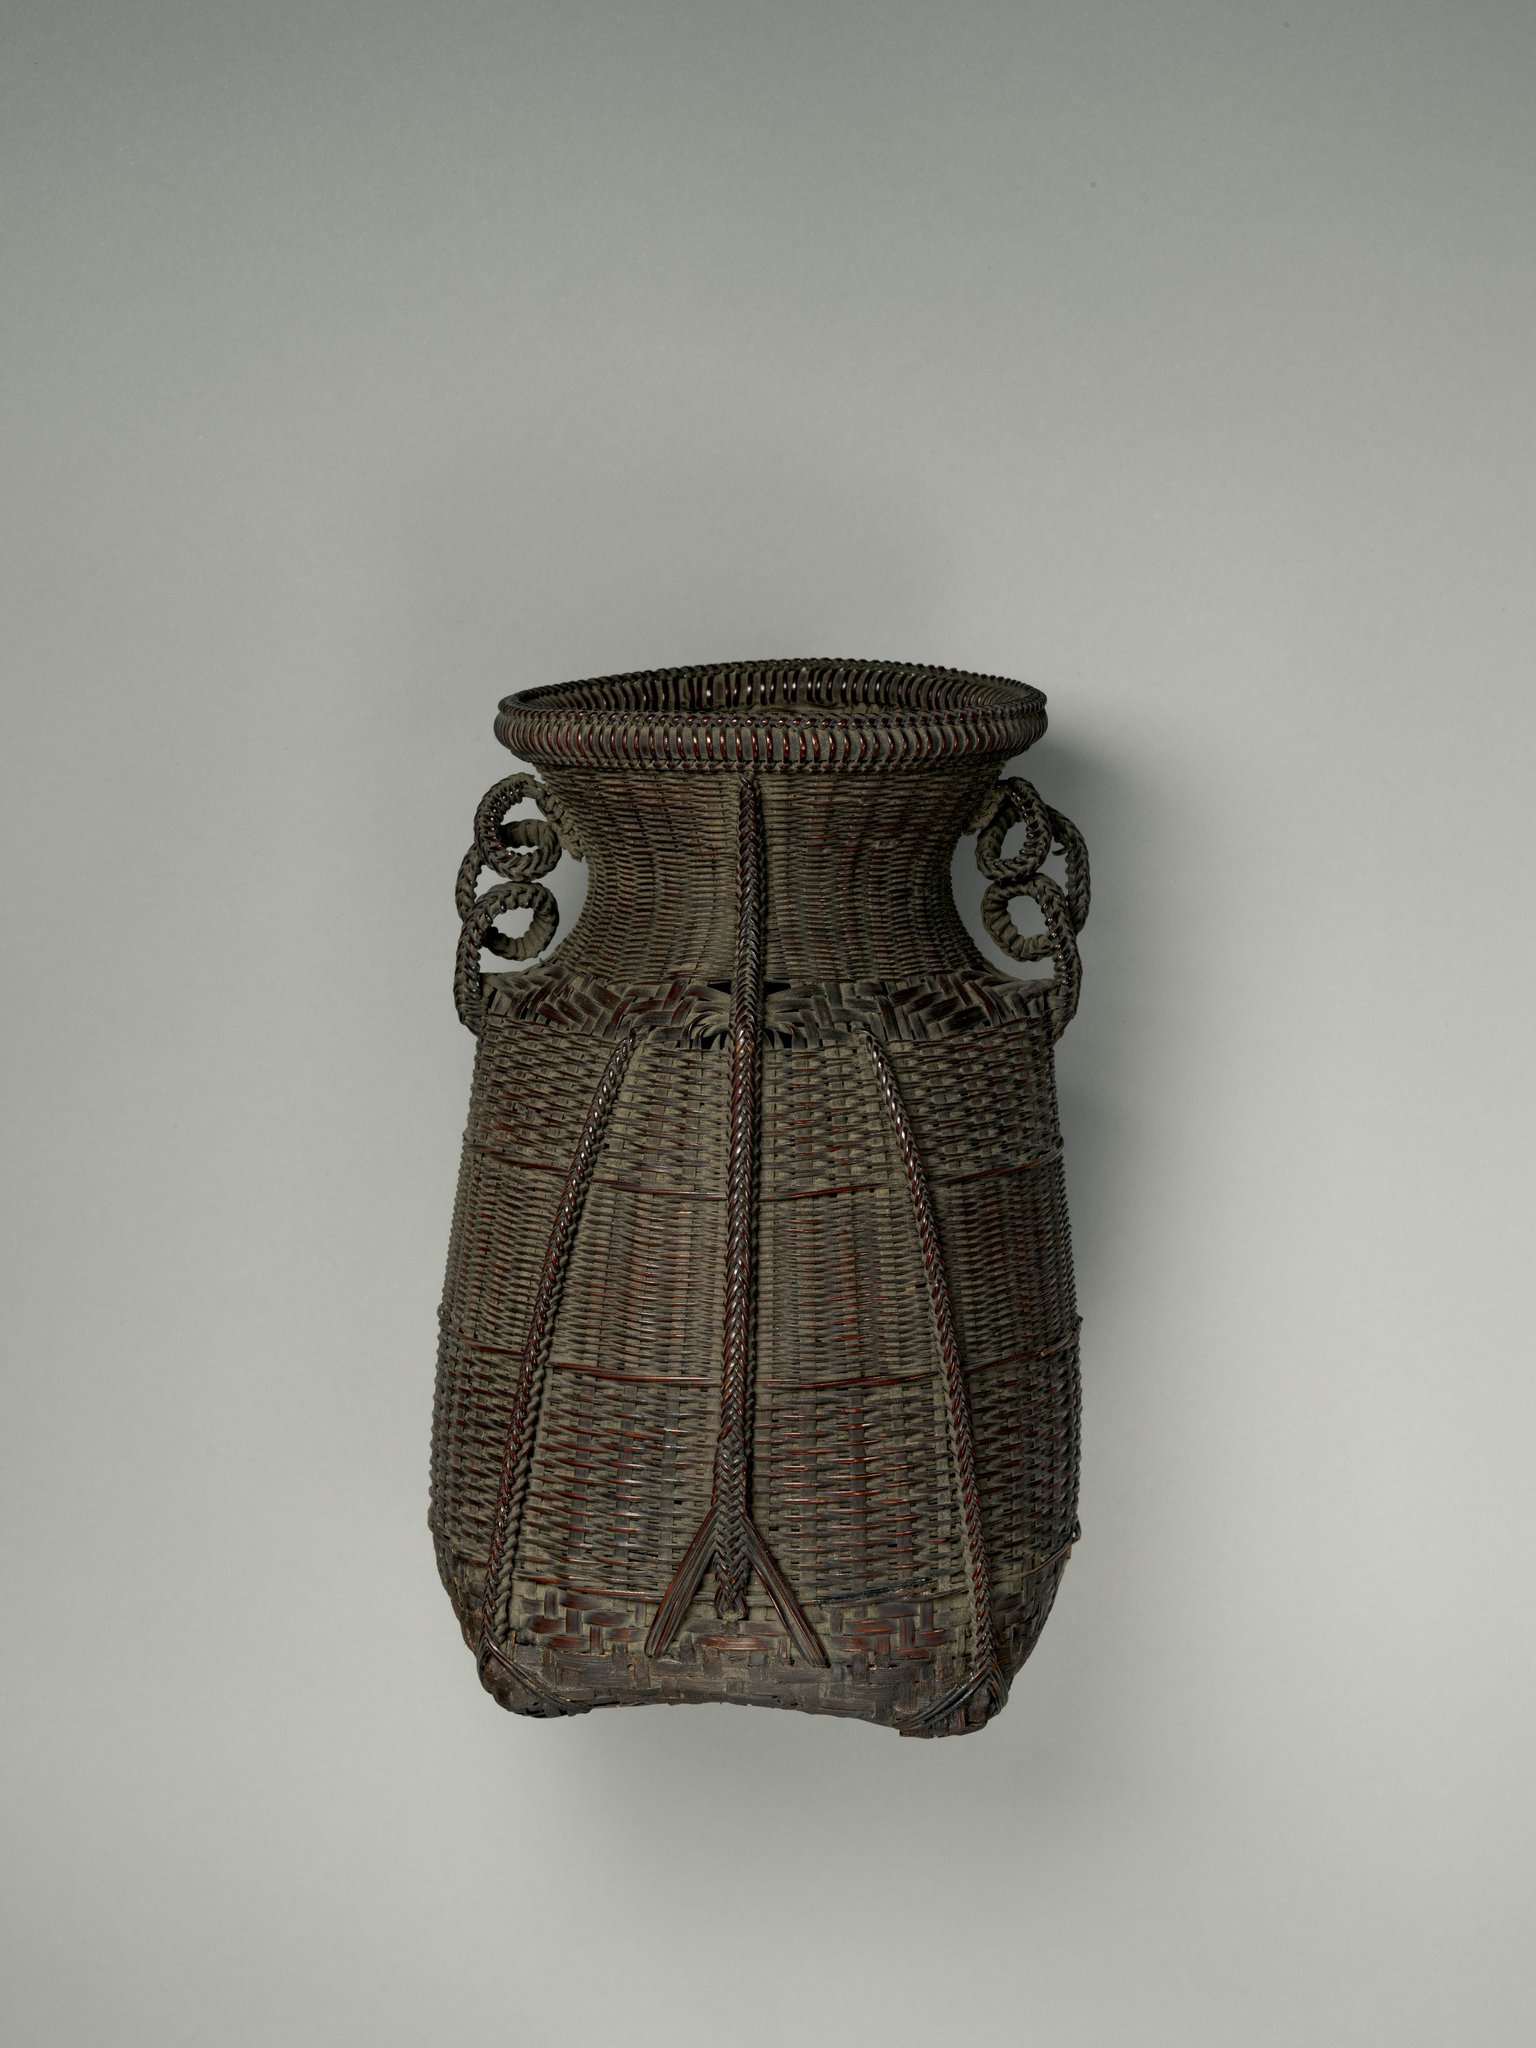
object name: basket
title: Flower Basket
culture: japanese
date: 1834-1866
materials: bamboo, lacquer